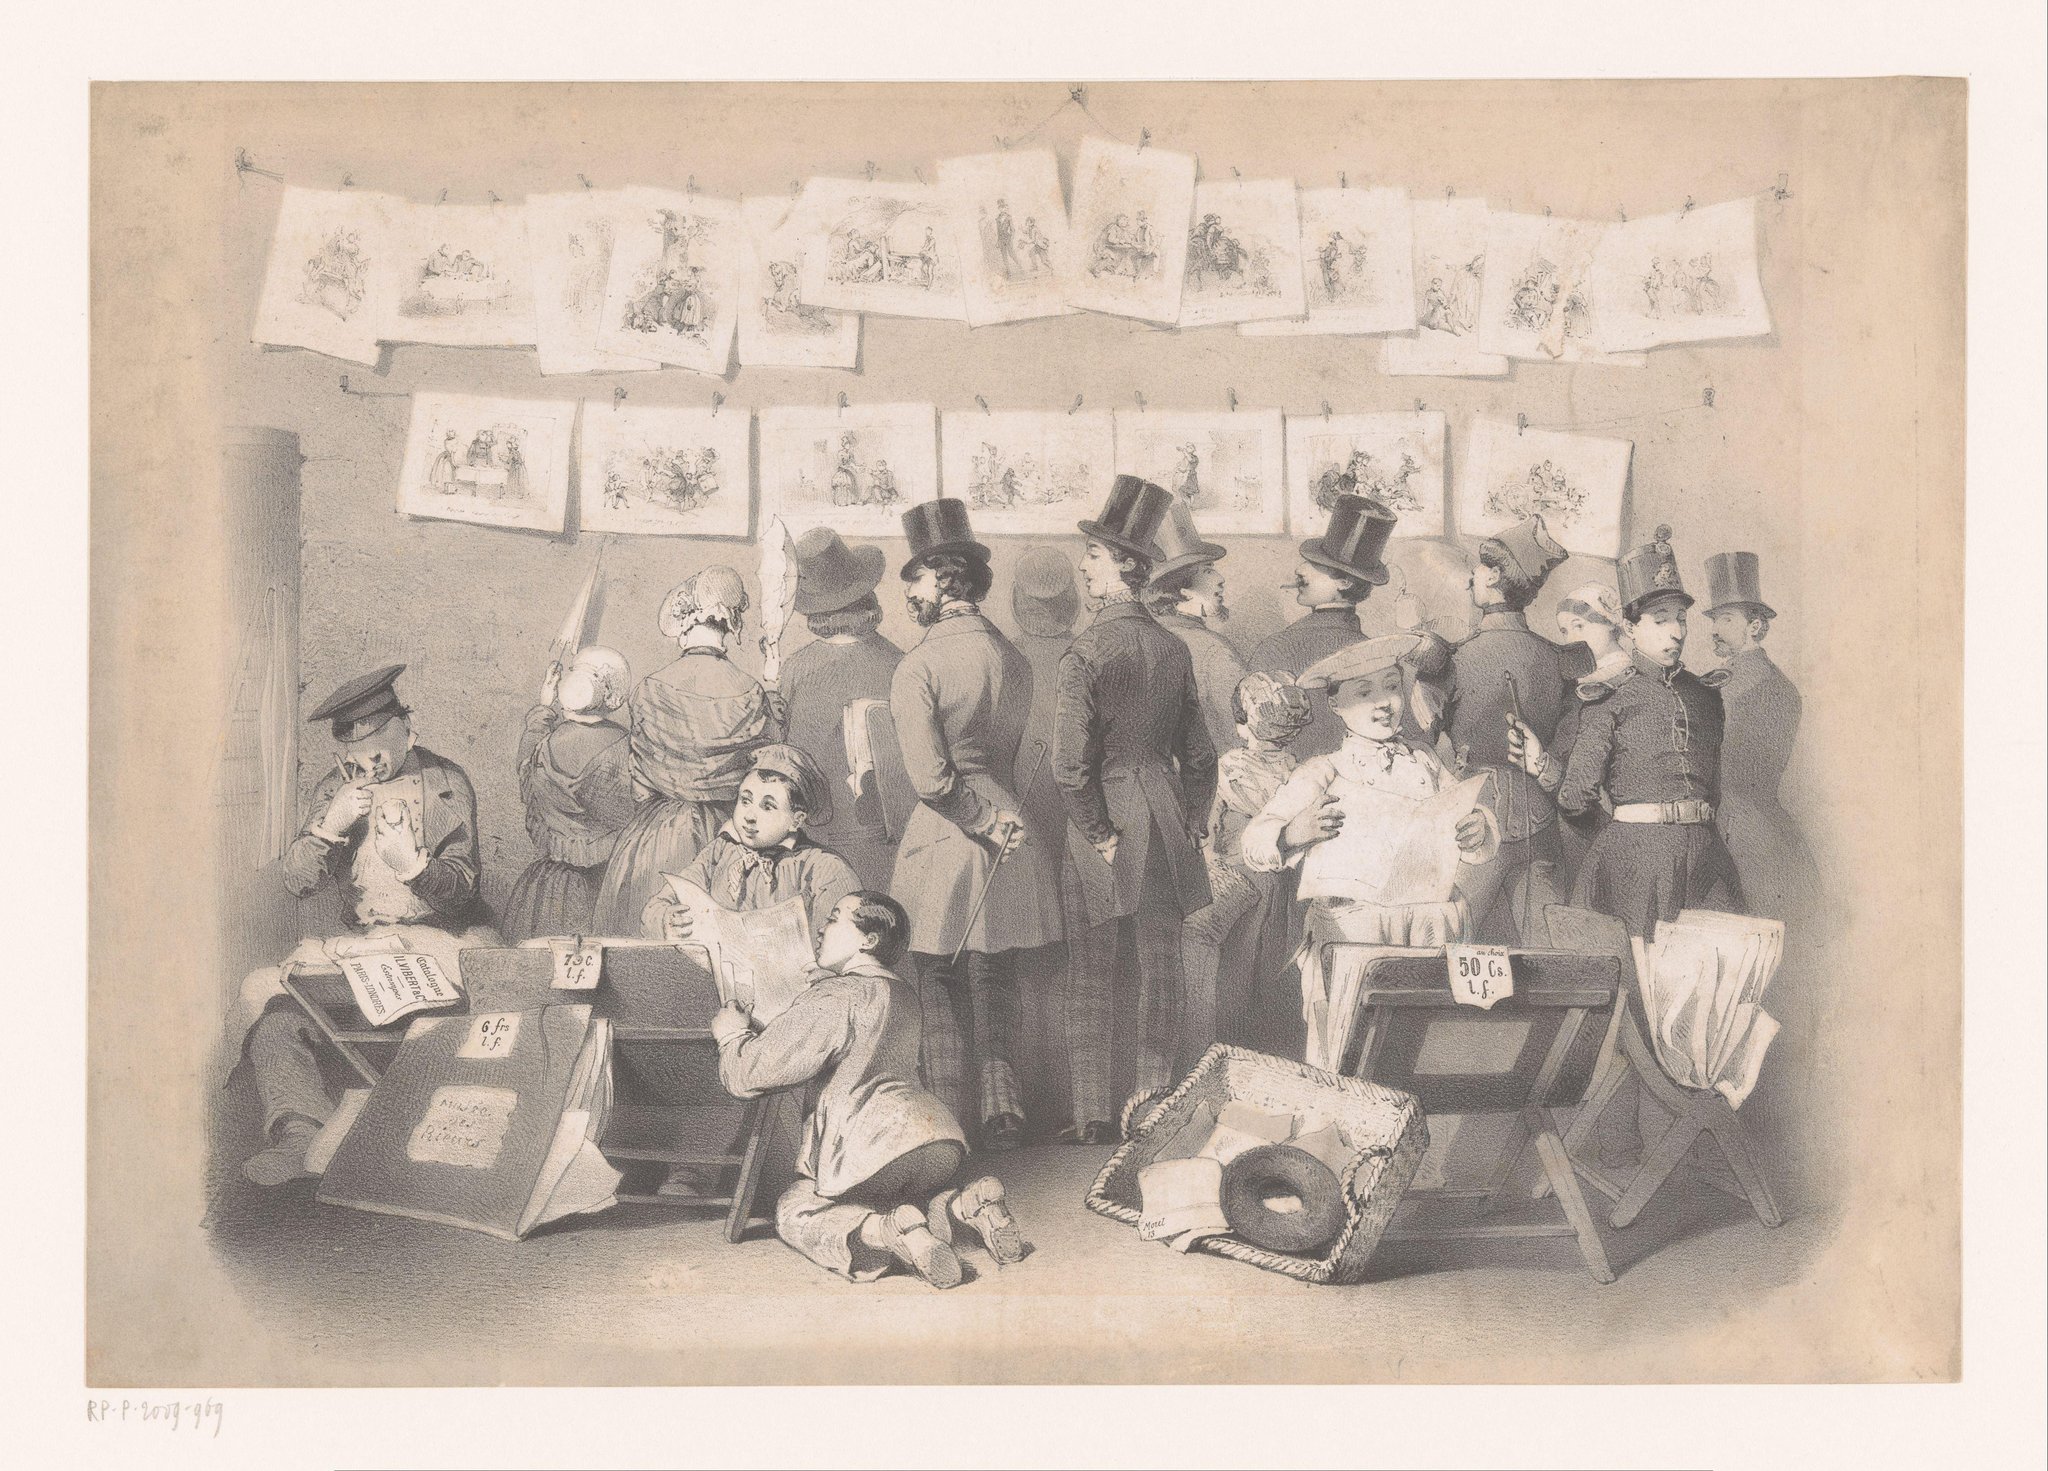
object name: titelprent, frontispice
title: Musée des Rieurs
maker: victor jean françois dollet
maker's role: print maker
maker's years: 1815-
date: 1850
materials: paper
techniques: tone lithography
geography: paris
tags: art trade, art shop, print, e.g.: engraving, etching, lithograph, head-gear: hat (+ men's clothes)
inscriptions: collector's mark: Lugt 2228a, collector's mark: Lugt 2760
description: Interieur van prentenwinkel Goupil, Vibert & Cie. Links voor bekijken twee kinderen prenten uit de reeks 'Musée des Rieurs'. Een groep van twaalf personen - heren in pak, kinderen, een soldaat en vrouwen - bewonderen prenten die uitgestald zijn hangend aan een koord op de muur. Op de voorgrond rechts houdt een jongen in wit pak een prent in handen terwijl een agent hem nauwlettend in de gaten houdt.